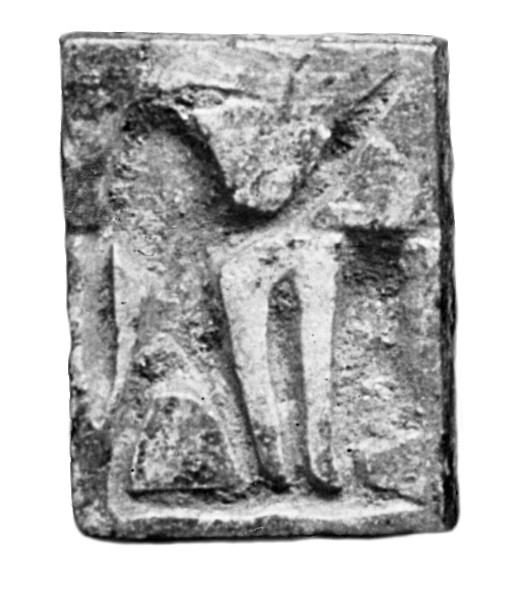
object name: plaque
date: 1550-1070 BCE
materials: faience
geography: egypt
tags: scarabs